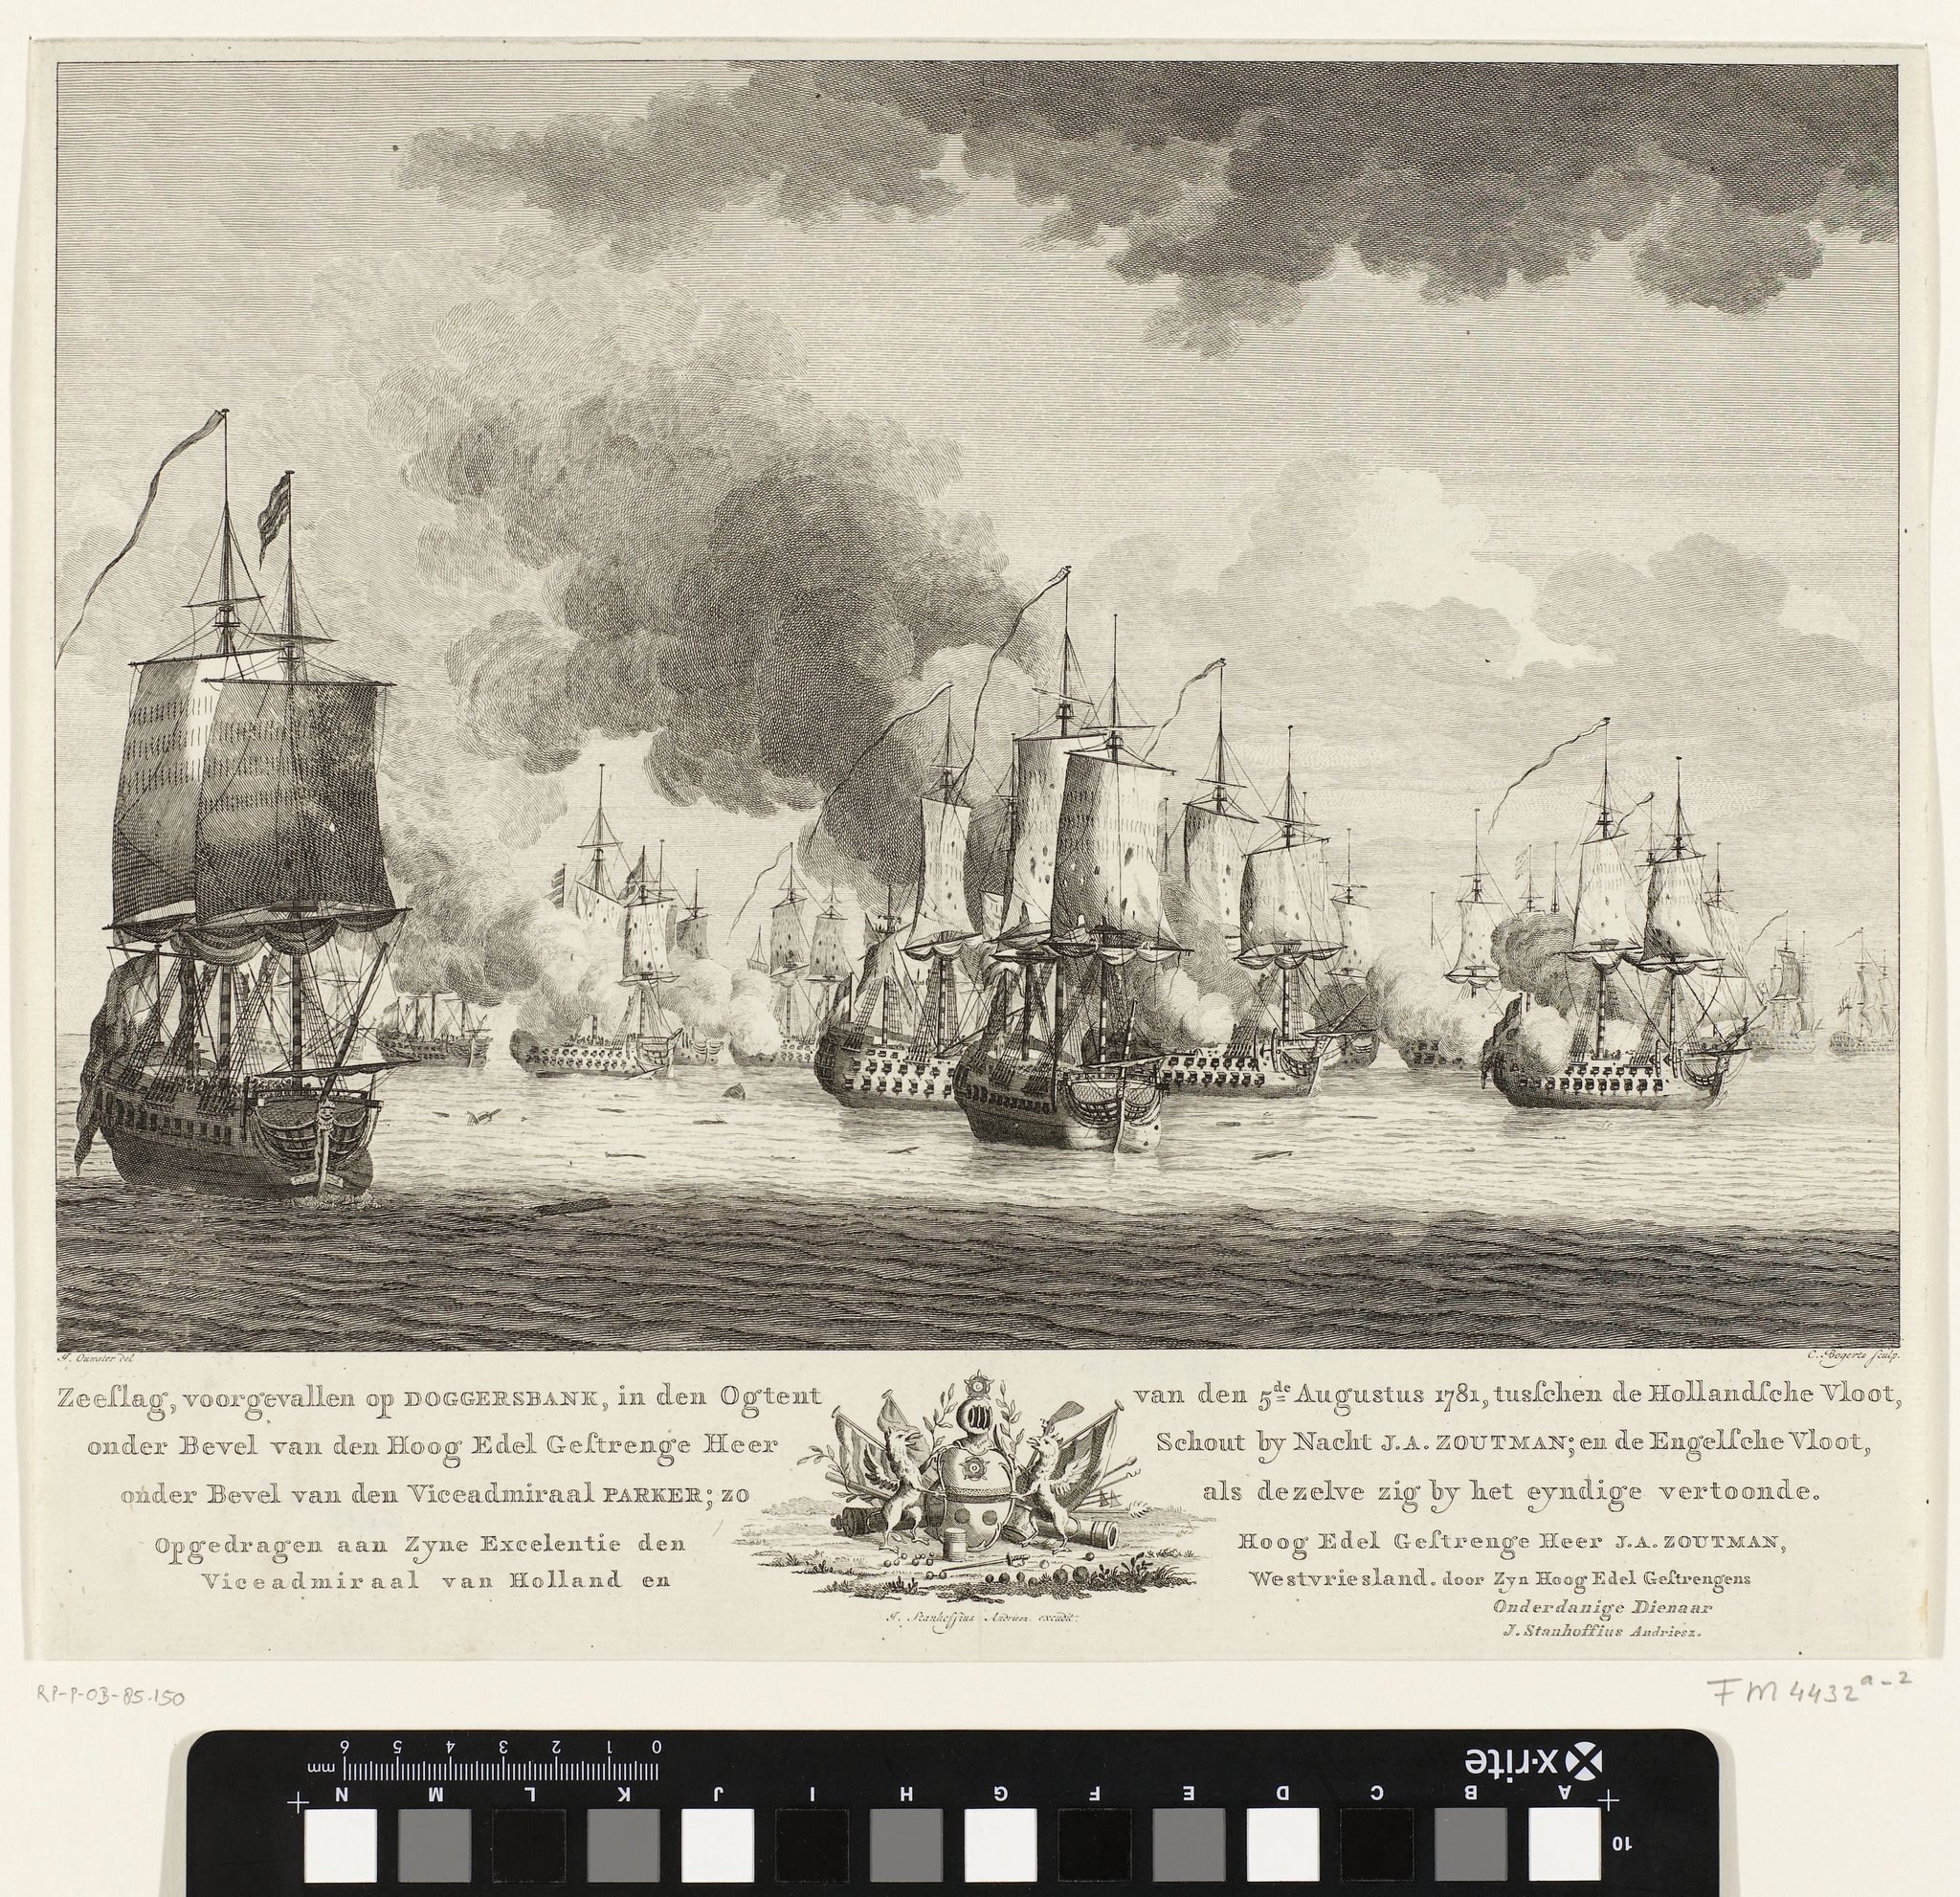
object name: print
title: Zeeslag, voorgevallen op Doggersbank, in den Ogtent van den 5de Augustus 1781, tusschen de Hollandsche Vloot (...)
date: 1781-1784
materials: paper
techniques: engraving, etching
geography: amsterdam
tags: the hague, johan arnold zoutman, hyde parker, battle (+ naval force)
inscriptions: collector's mark: Lugt 2228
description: De Nederlandse en Engelse schepen tijdens de zeeslag bij Doggersbank op 5 augustus 1781 tussen de Nederlandse vloot onder schout-bij-nacht Johan Zoutman en de Engelse vloot onder vice-admiraal Hyde Parker. In de marge de titel en opdracht in het Nederlands en in het midden het wapen van Zoutman. Onderdeel van een paar. Bij de prent behoort een tekstblad met verklaring.